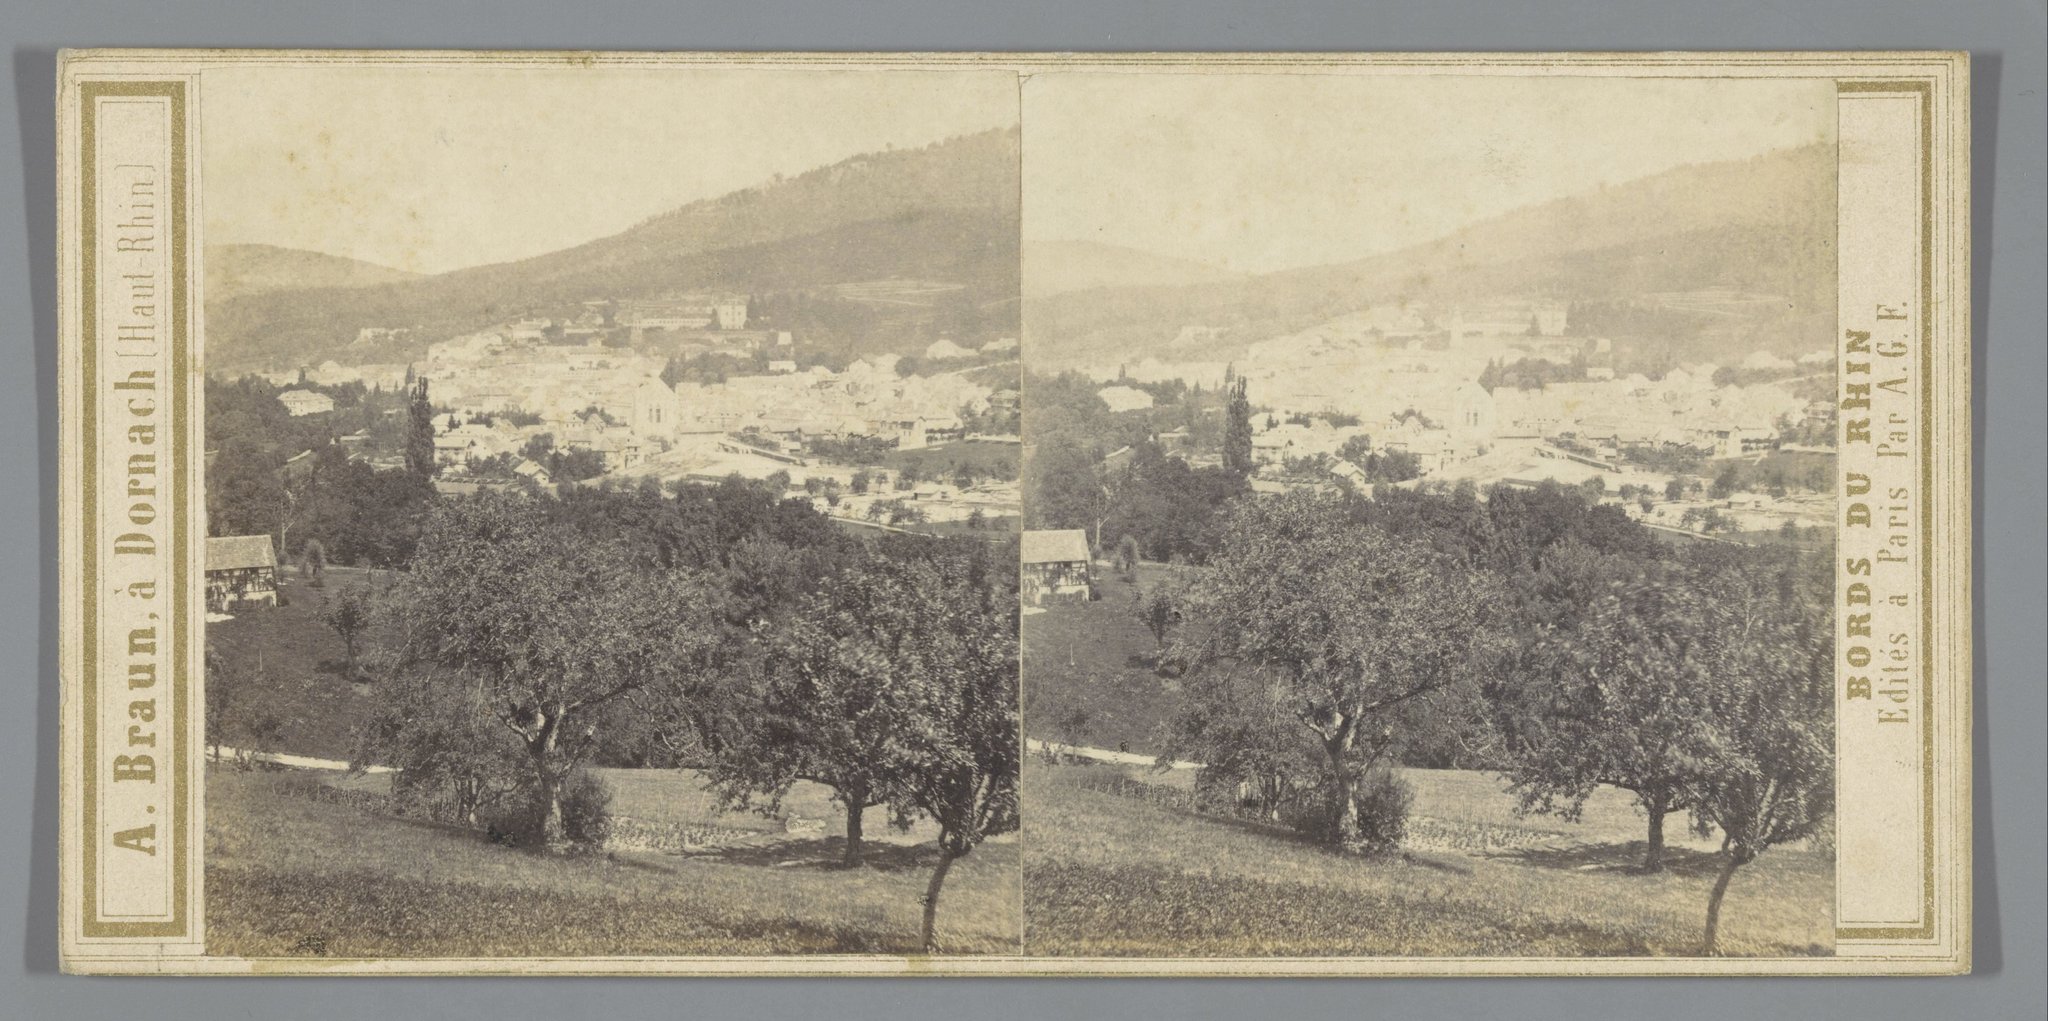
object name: stereograph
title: Bade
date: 1860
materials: cardboard, paper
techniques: albumen print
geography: paris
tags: city-view in general; 'veduta'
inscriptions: number: ‘899.’